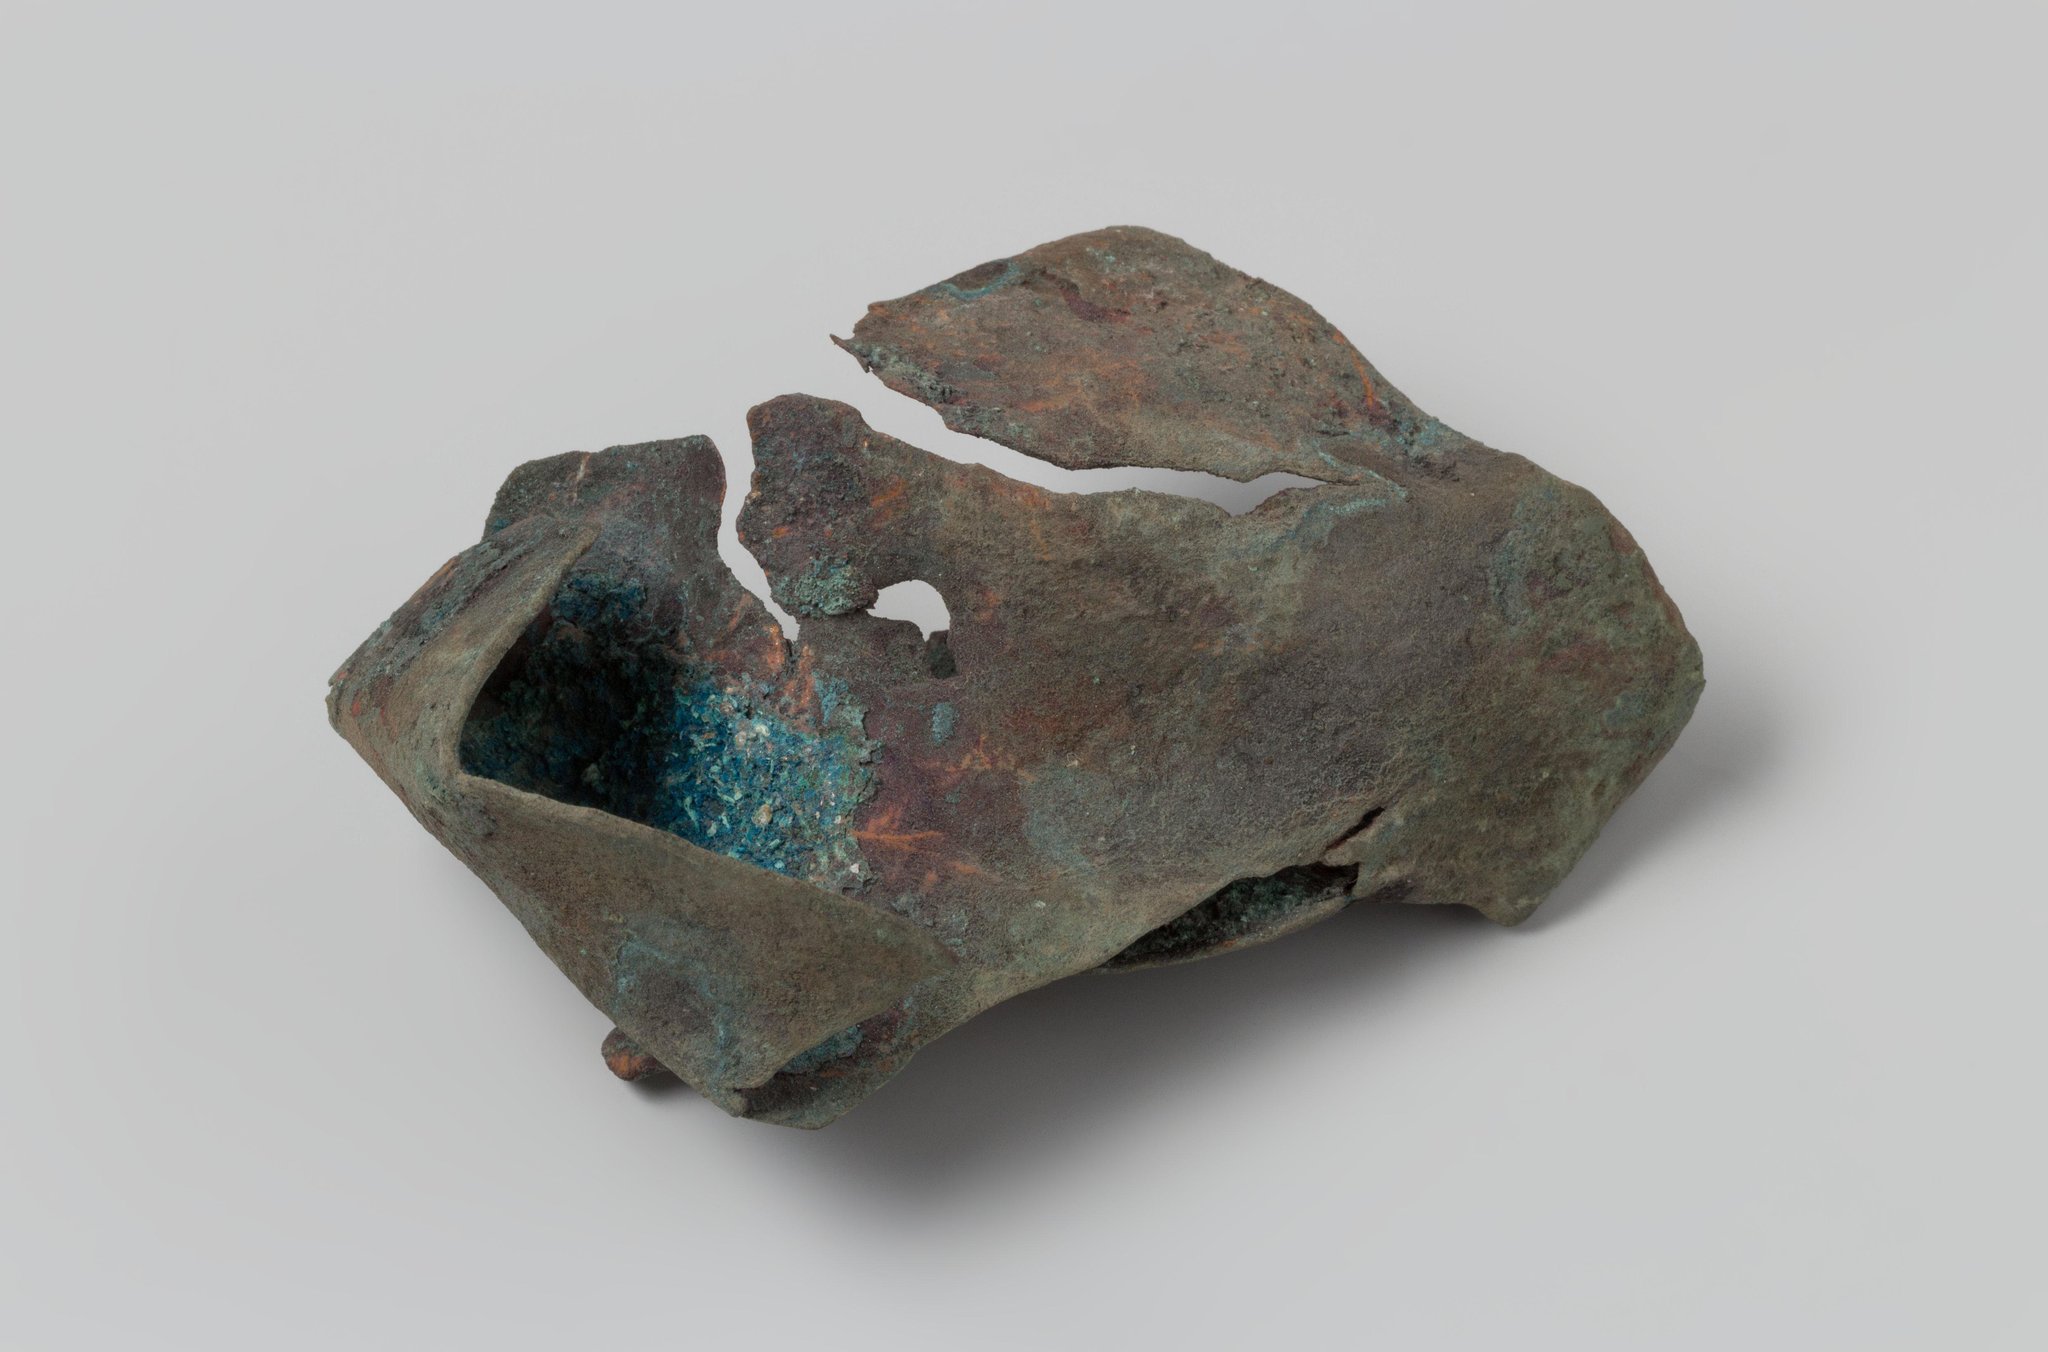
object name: scheepswrakvondst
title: Fragment van koper uit het wrak van de Oost-Indiëvaarder Hollandia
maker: Anonymous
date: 1700-1743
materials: copper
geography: netherlands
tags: verenigde oostindische compagnie, hollandia (schip), annet